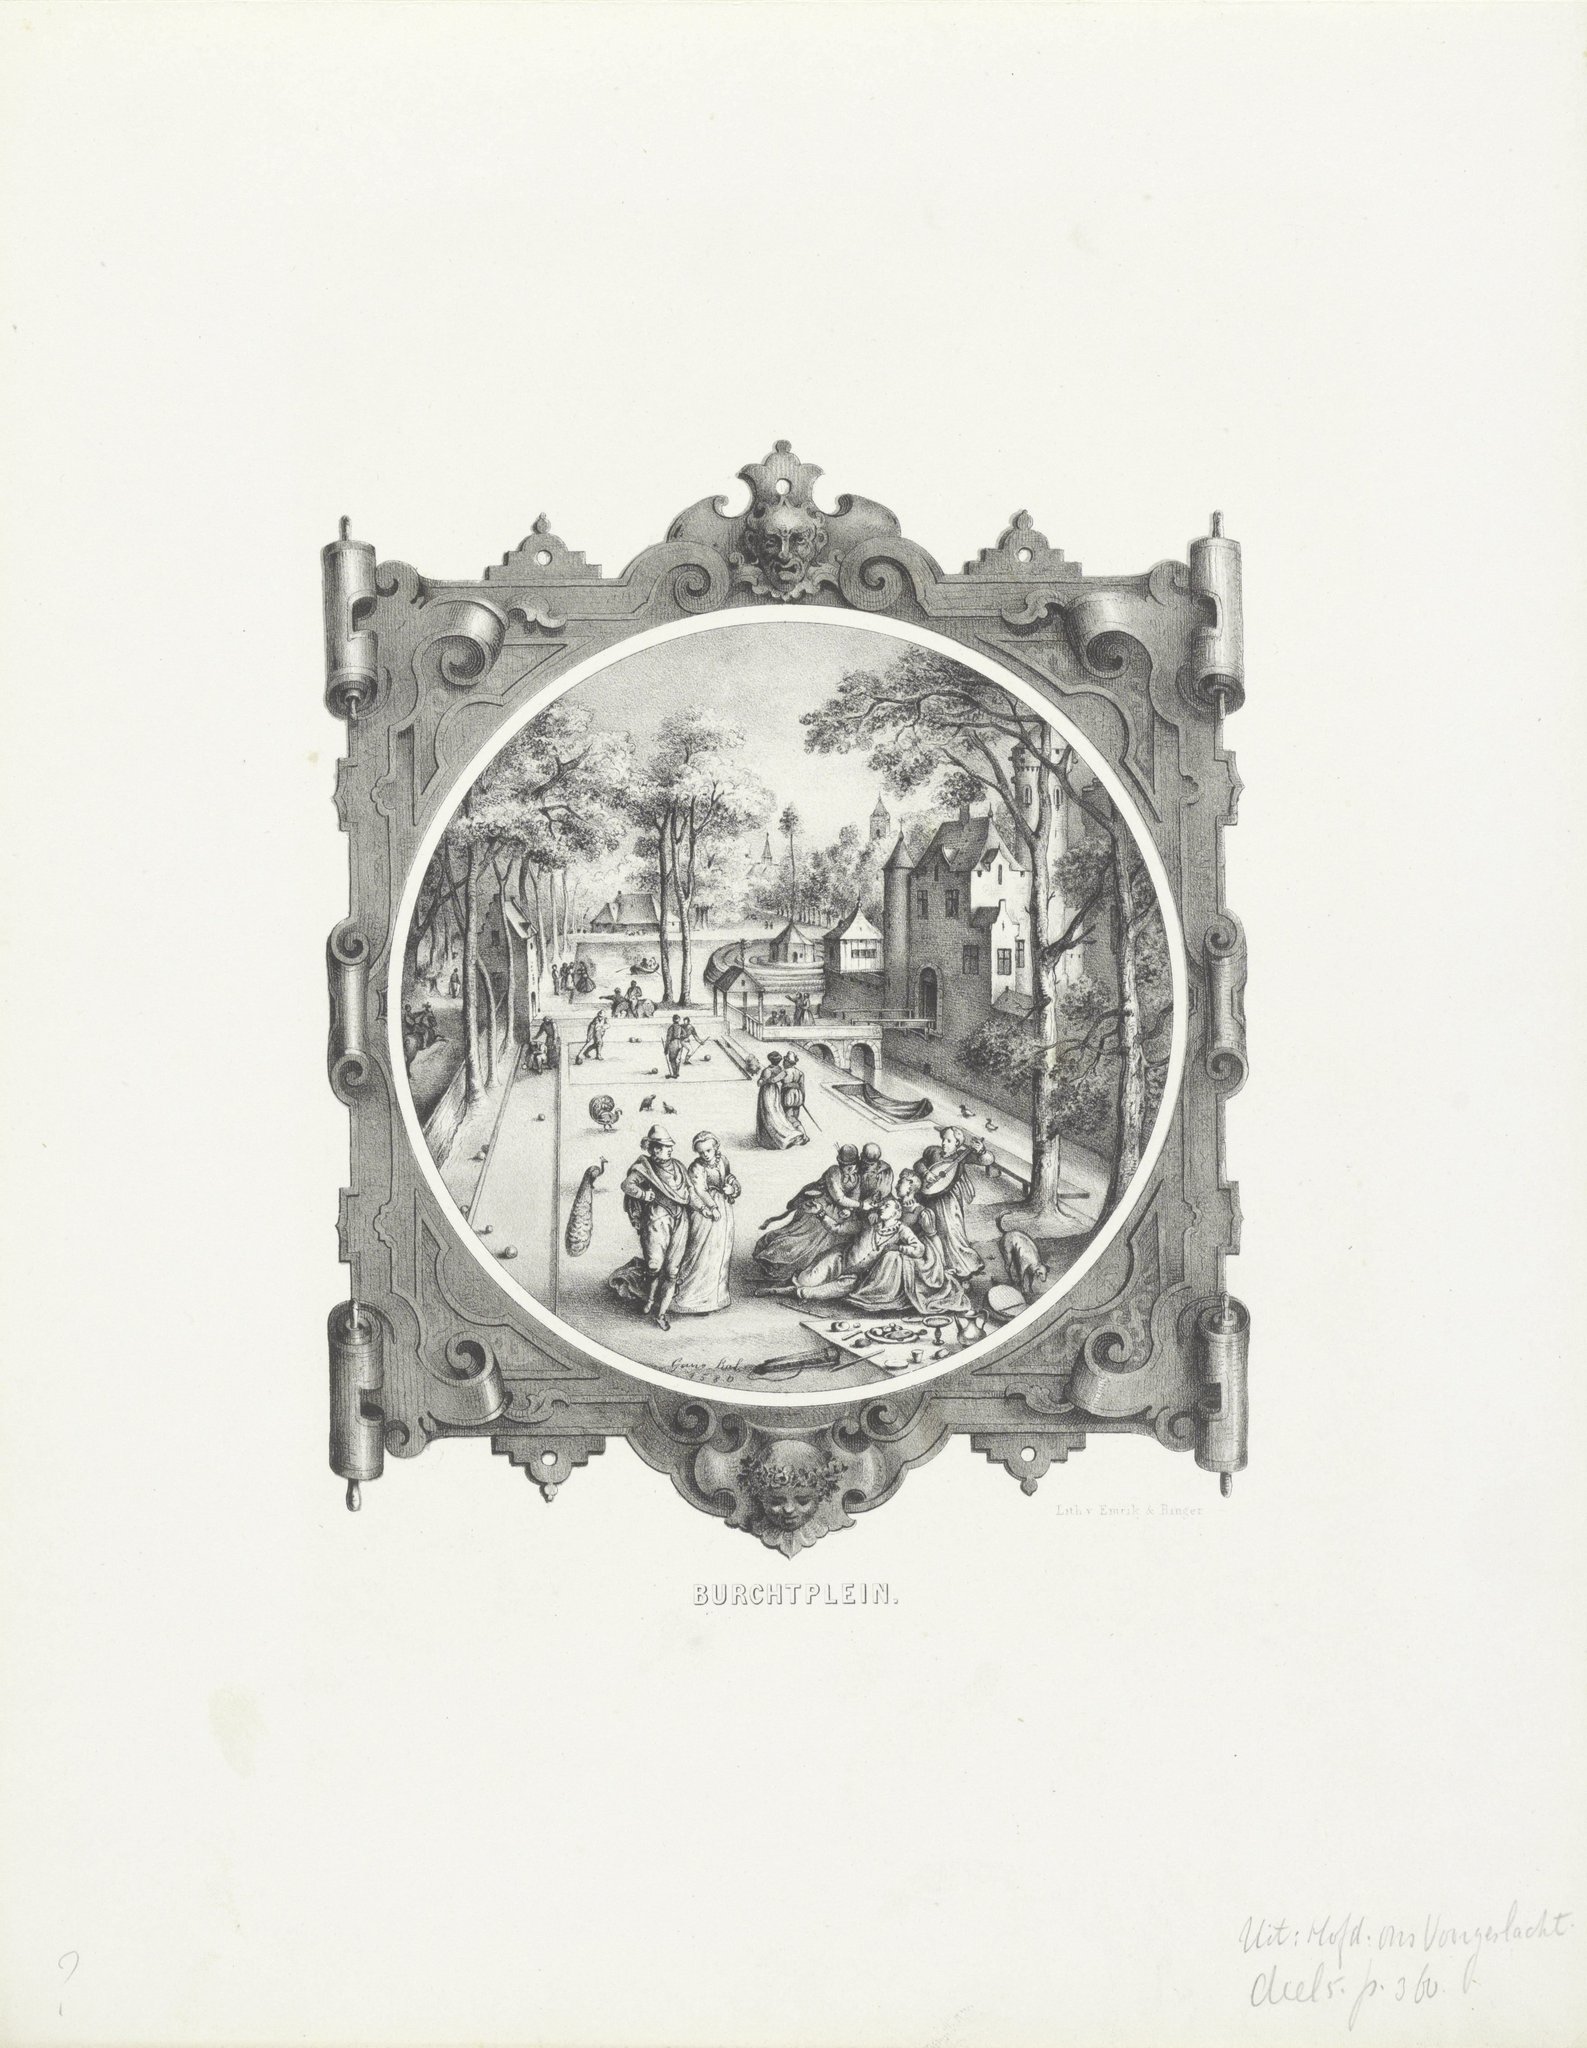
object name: book illustration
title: Burchtplein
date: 1857-1864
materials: paper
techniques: lithograph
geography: haarlem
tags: public gardens, park (+ city(-scape) with figures, staffage), birds, private festivities, merry company - aa - in the open air, 'fête champêtre', village square, place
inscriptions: collector's mark: Lugt 2228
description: Prent voor: Hofdijk, W. J. Ons Voorgeslacht, 1859-64. De oorspronkelijke tekening door Hans Bol, 'De maand mei', maakte deel uit van een serie van twaalf tekeningen met afbeeldingen van de maanden van het jaar. Deze tekening is gedateerd 1580 en bevindt zich in het Museum Boijmans van Beuningen in Rotterdam.